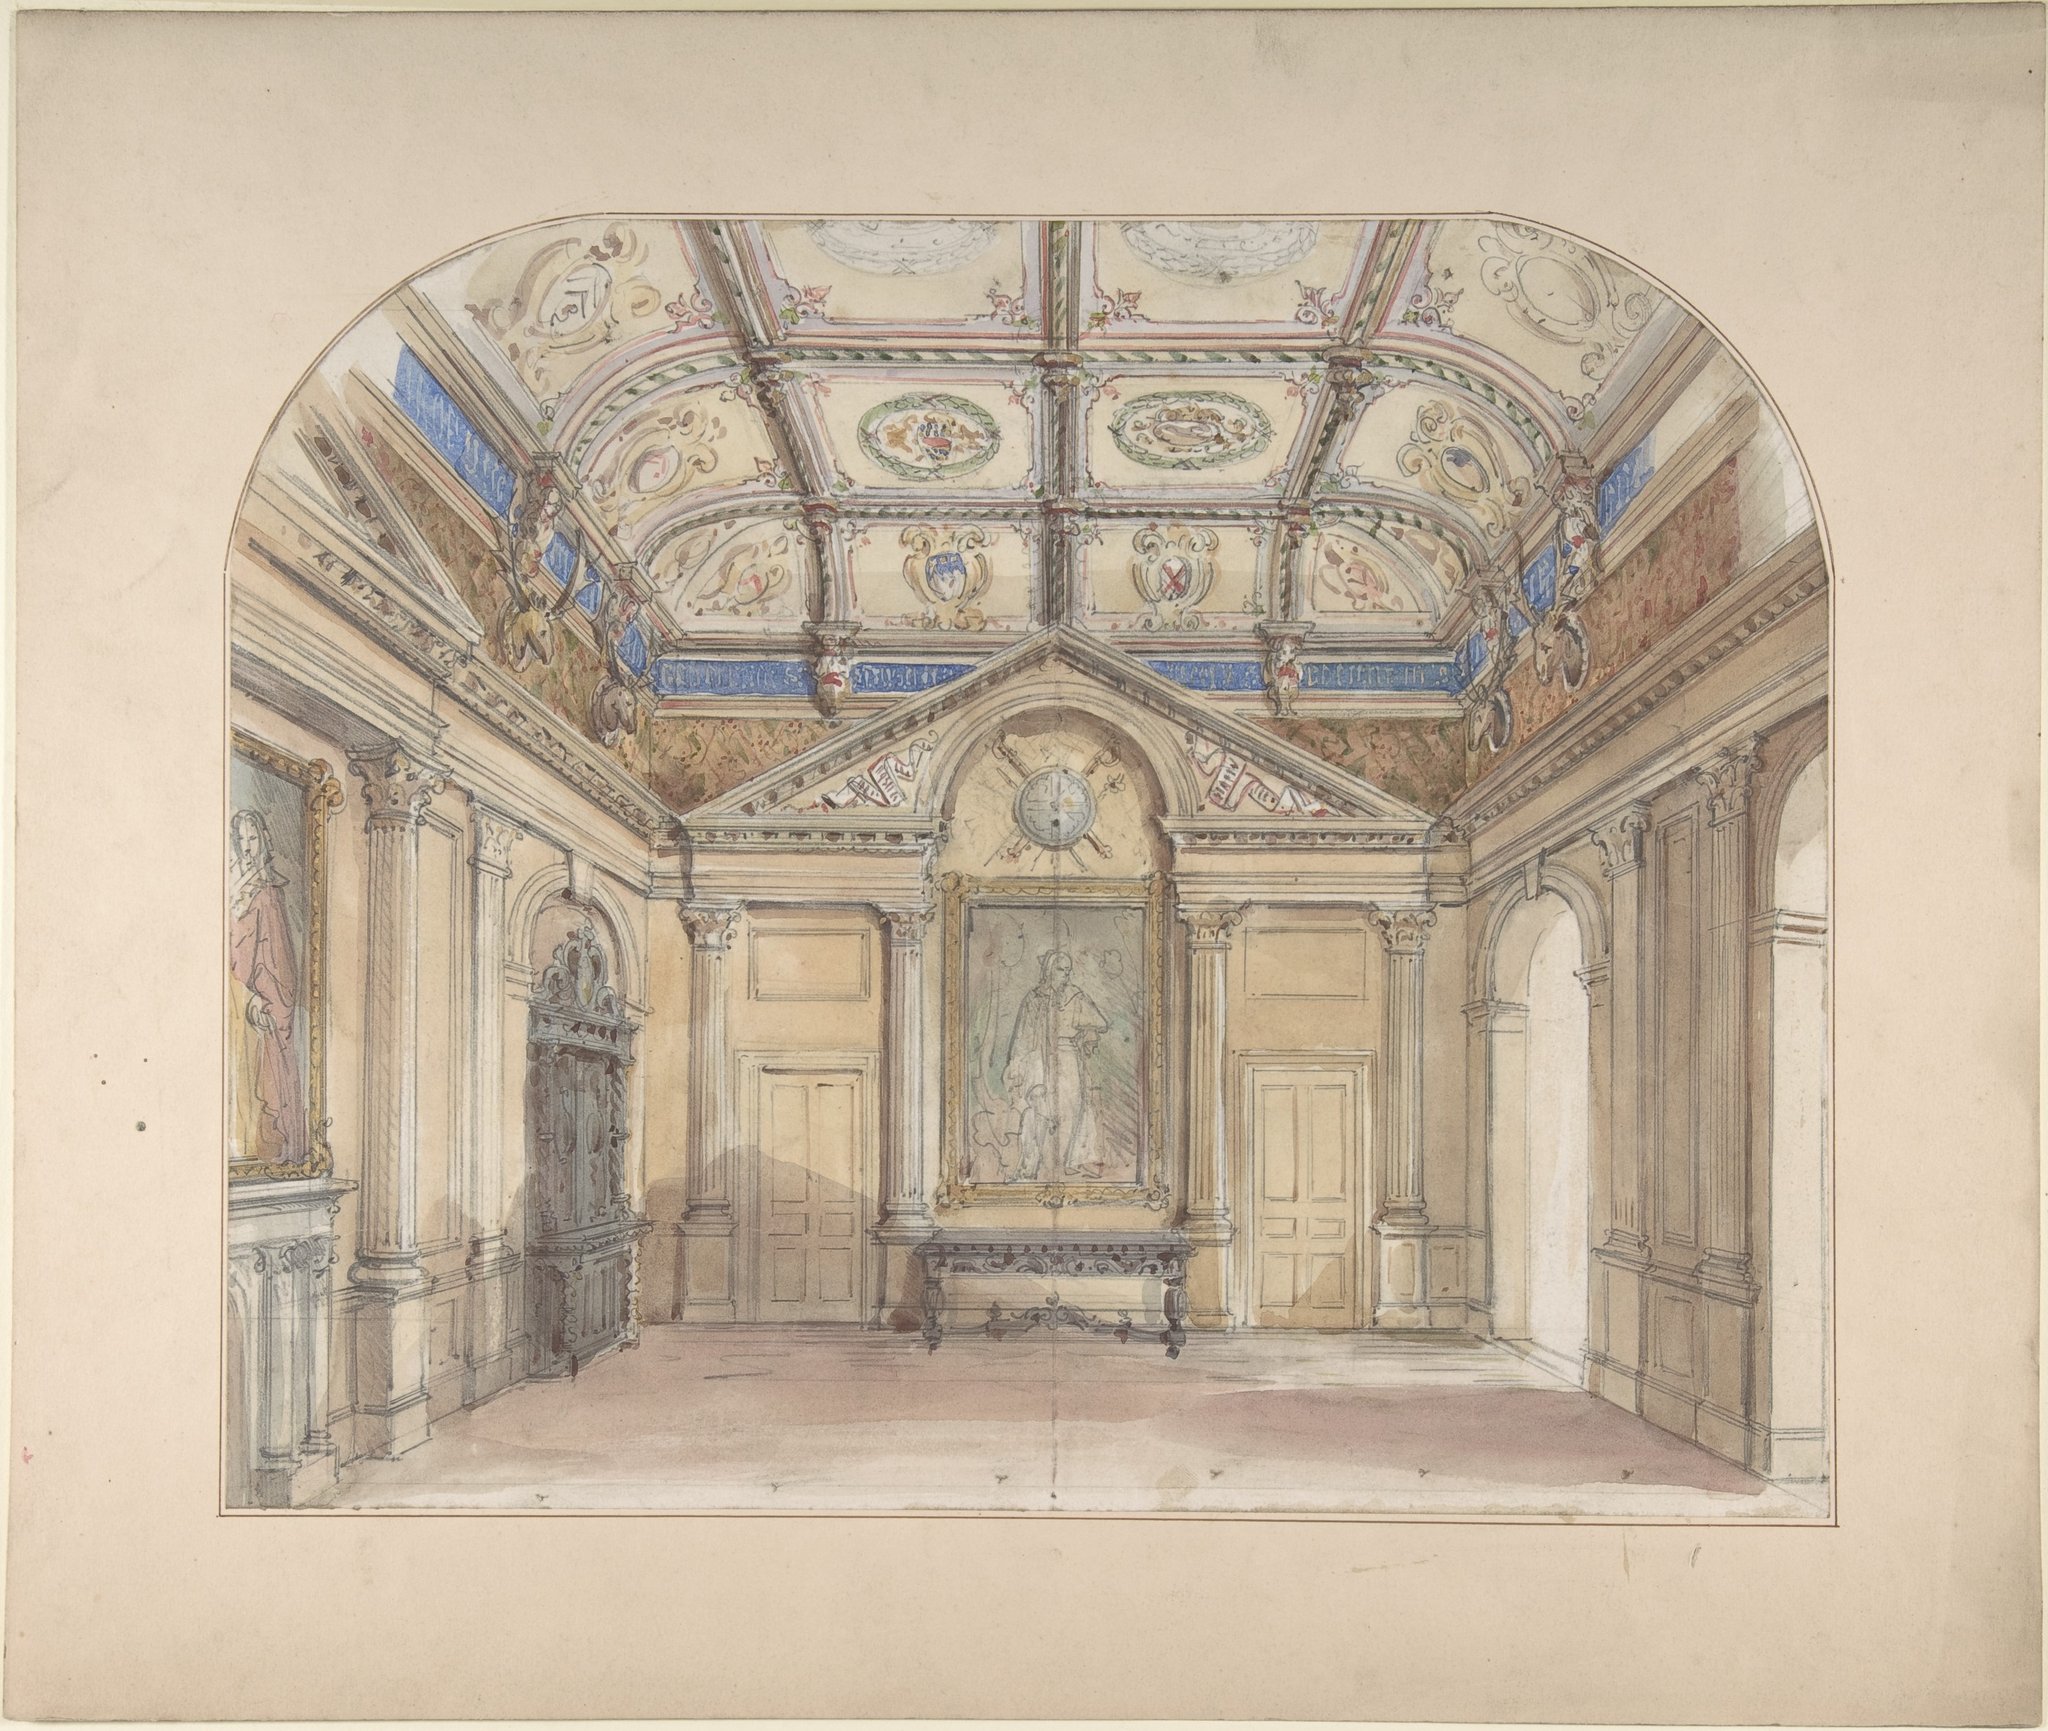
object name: drawing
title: Interior with coffered ceiling and Corinthian order applied to walls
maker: john gregory crace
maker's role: artist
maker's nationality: british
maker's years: 1809-1889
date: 1801-1900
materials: gilt, graphite, watercolor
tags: architecture,interiors